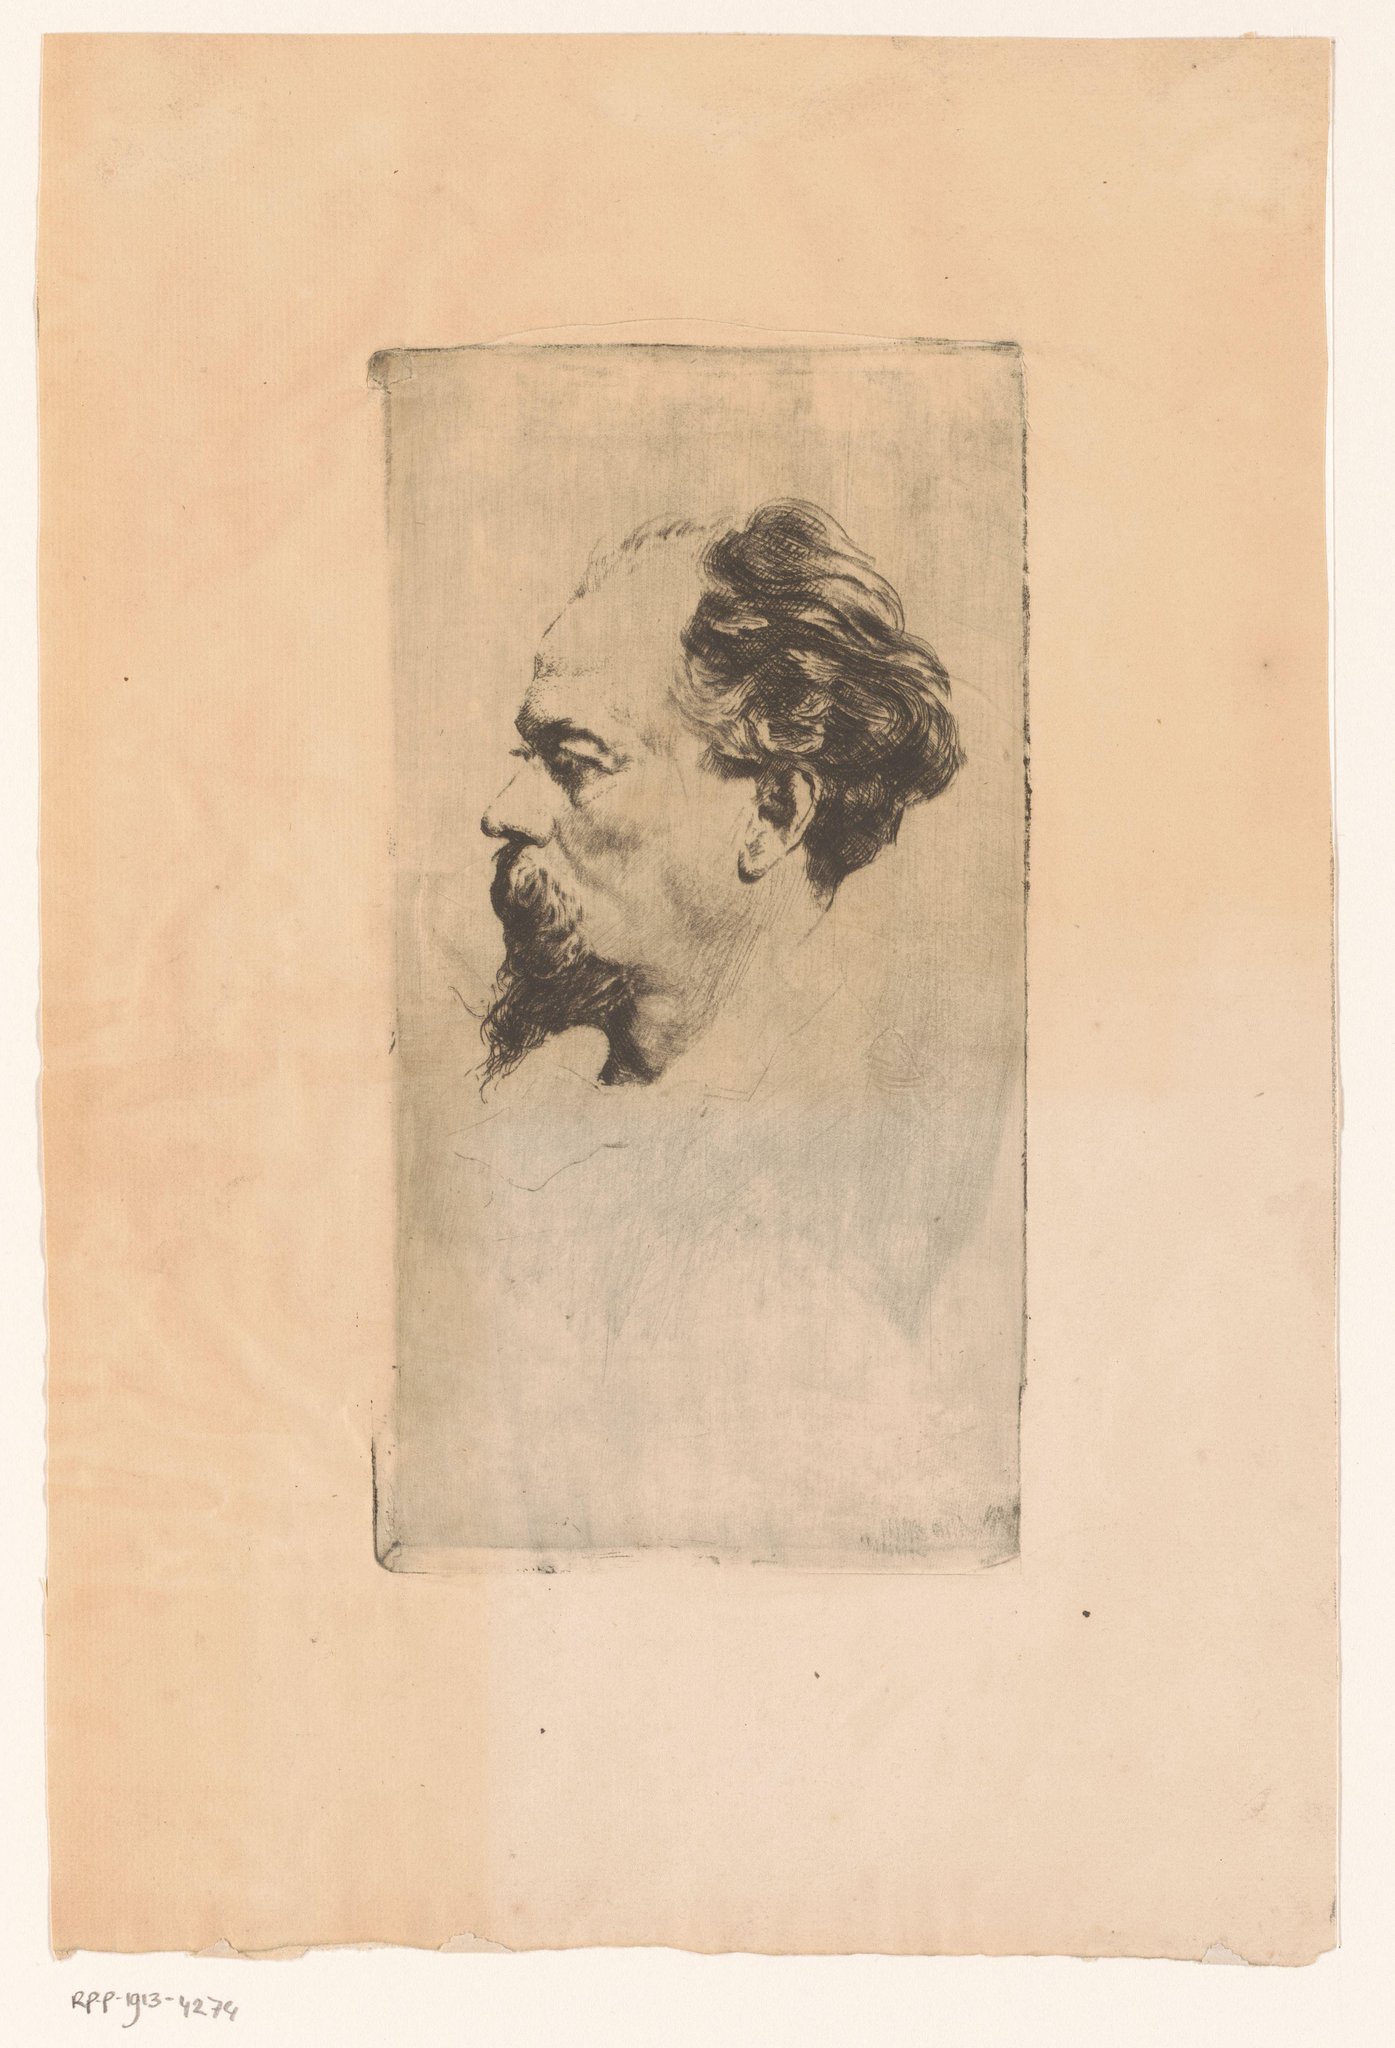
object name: print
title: Portret van Prosper Drion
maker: adrien de witte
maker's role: print maker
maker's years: 1850-1935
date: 1877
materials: paper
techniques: drypoint, etching, intaglio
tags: adult man, historical persons, beard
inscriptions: collector's mark: Lugt 2228